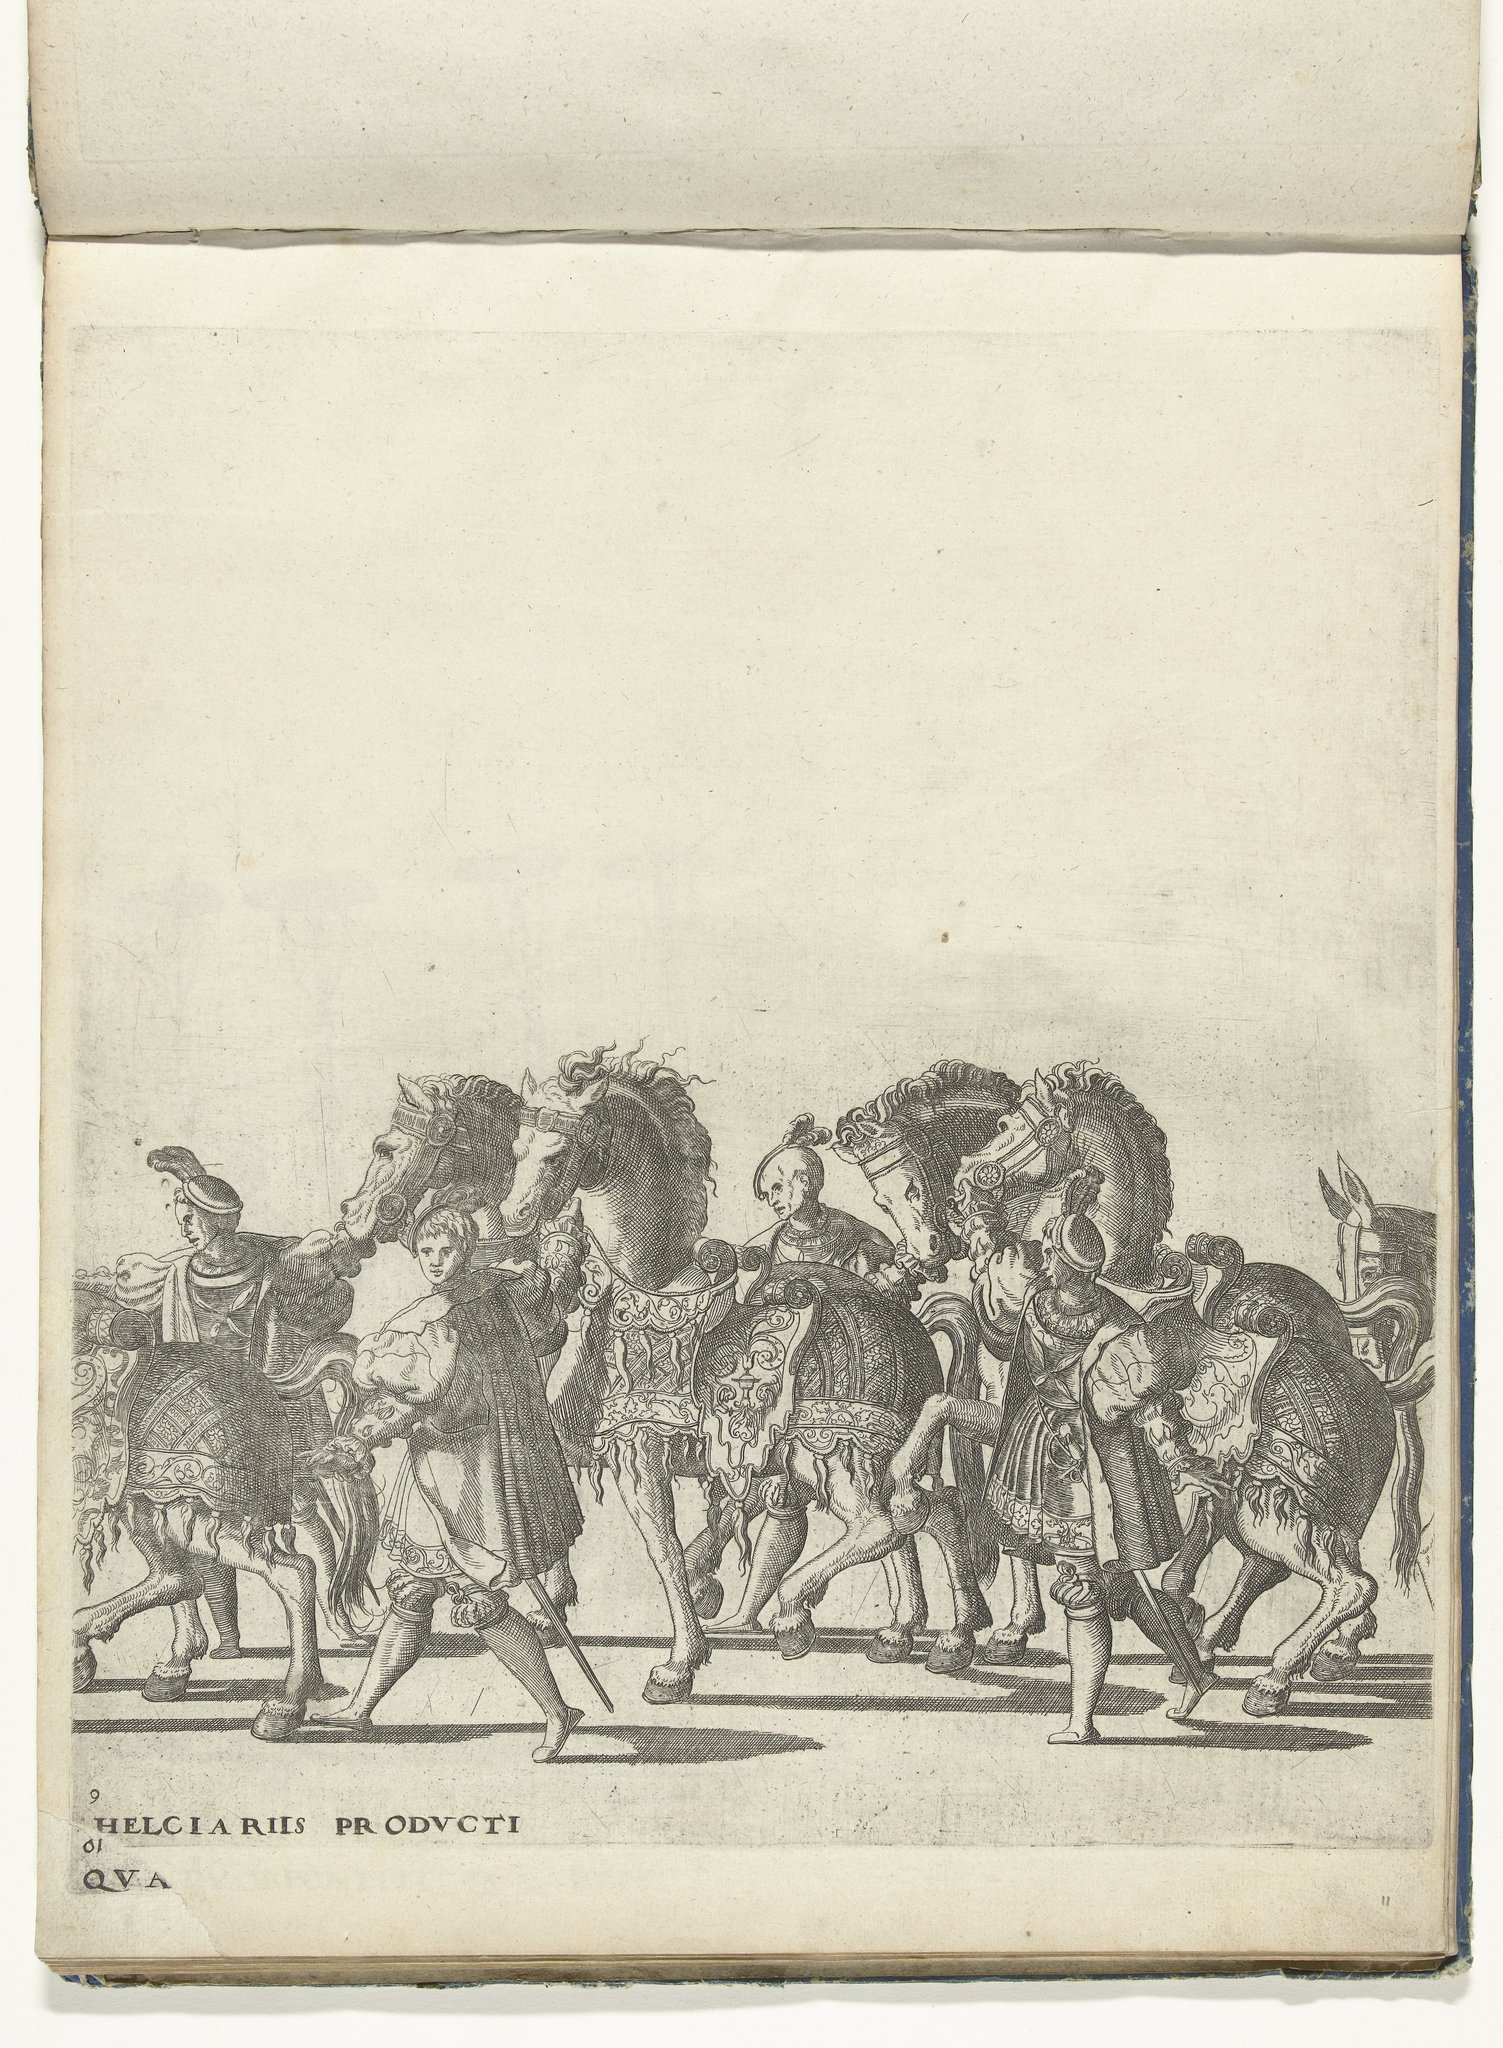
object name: propagandaprent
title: Optocht van Karel V met de paus te Bologna na zijn kroning to keizer, 1530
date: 1530-1536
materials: paper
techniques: engraving, etching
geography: the hague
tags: ghent, charles v (holy roman emperor and king of spain), rome, festivities (+ parade, pageant, cavalcade ~ festive activities)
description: Prent in het album waarin zijn ingeplakt de 40 platen die achterelkaar samen het fries vormen van de optocht van Karel V met de paus Clemens VII te Bologna na zijn kroning tot keizer, 24 februari 1530.